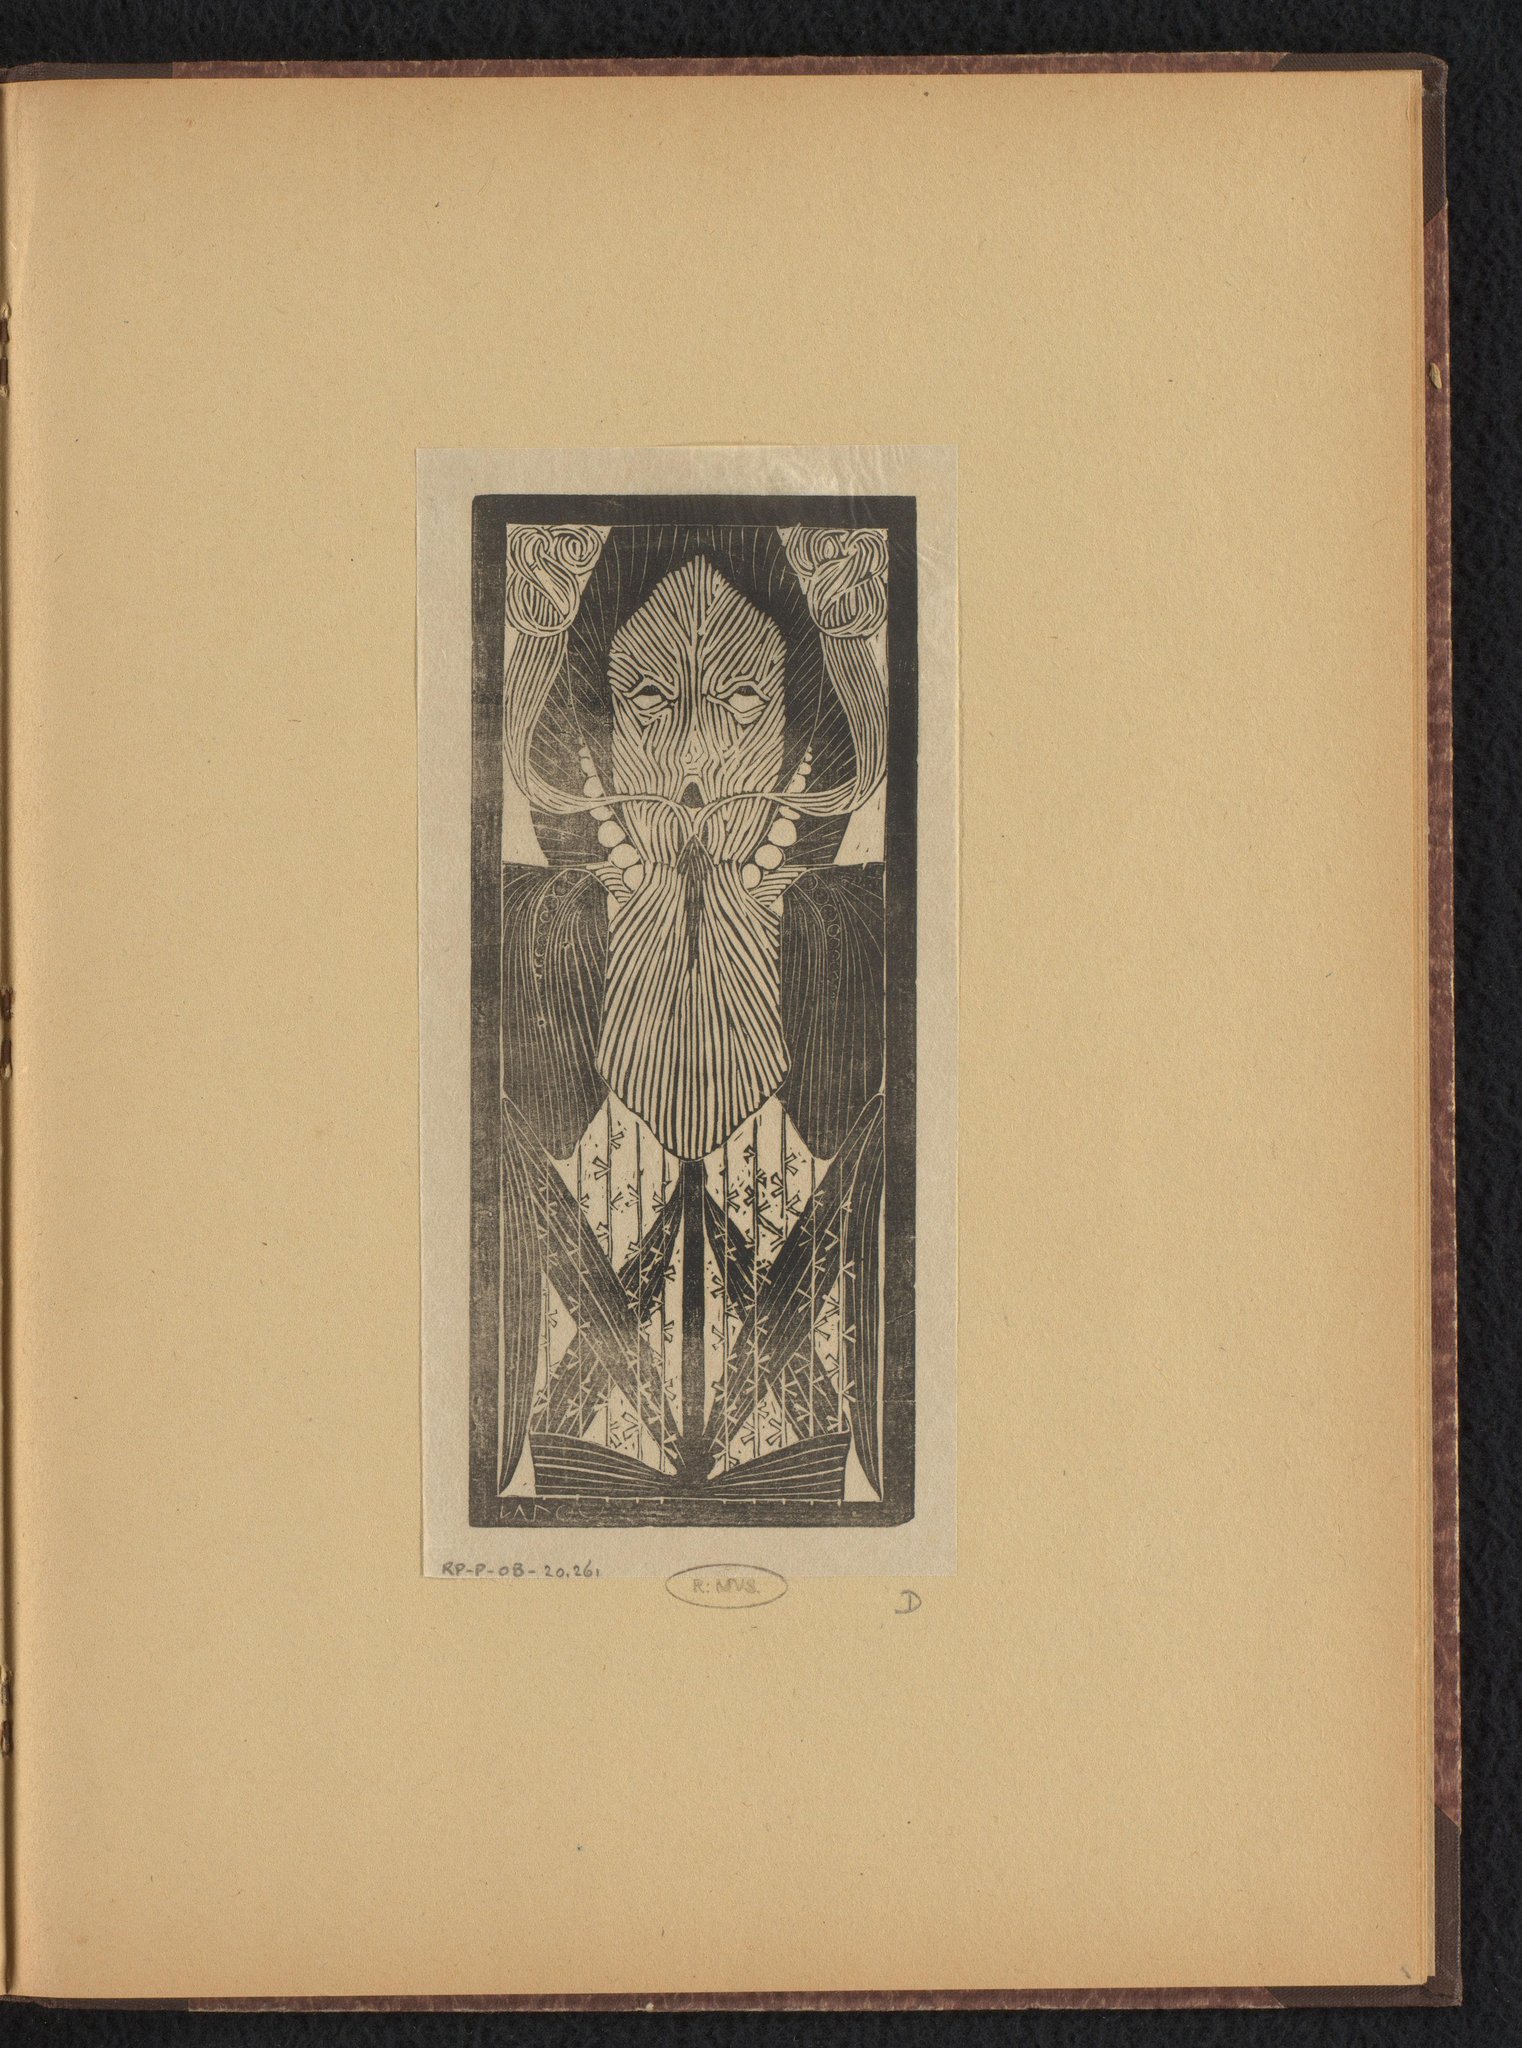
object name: album leaf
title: Bloemgezicht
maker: mathieu lauweriks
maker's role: designer, draughtsman, print maker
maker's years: 1864-1932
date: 1894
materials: paper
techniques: woodcut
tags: flowers, face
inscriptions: collector's mark: Lugt 2228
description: Een bloem, mogelijk een iris of lelie, waarvan het bovenste en onderste blad een menselijk gezicht vormen. Deze prent maakt deel uit van een album.